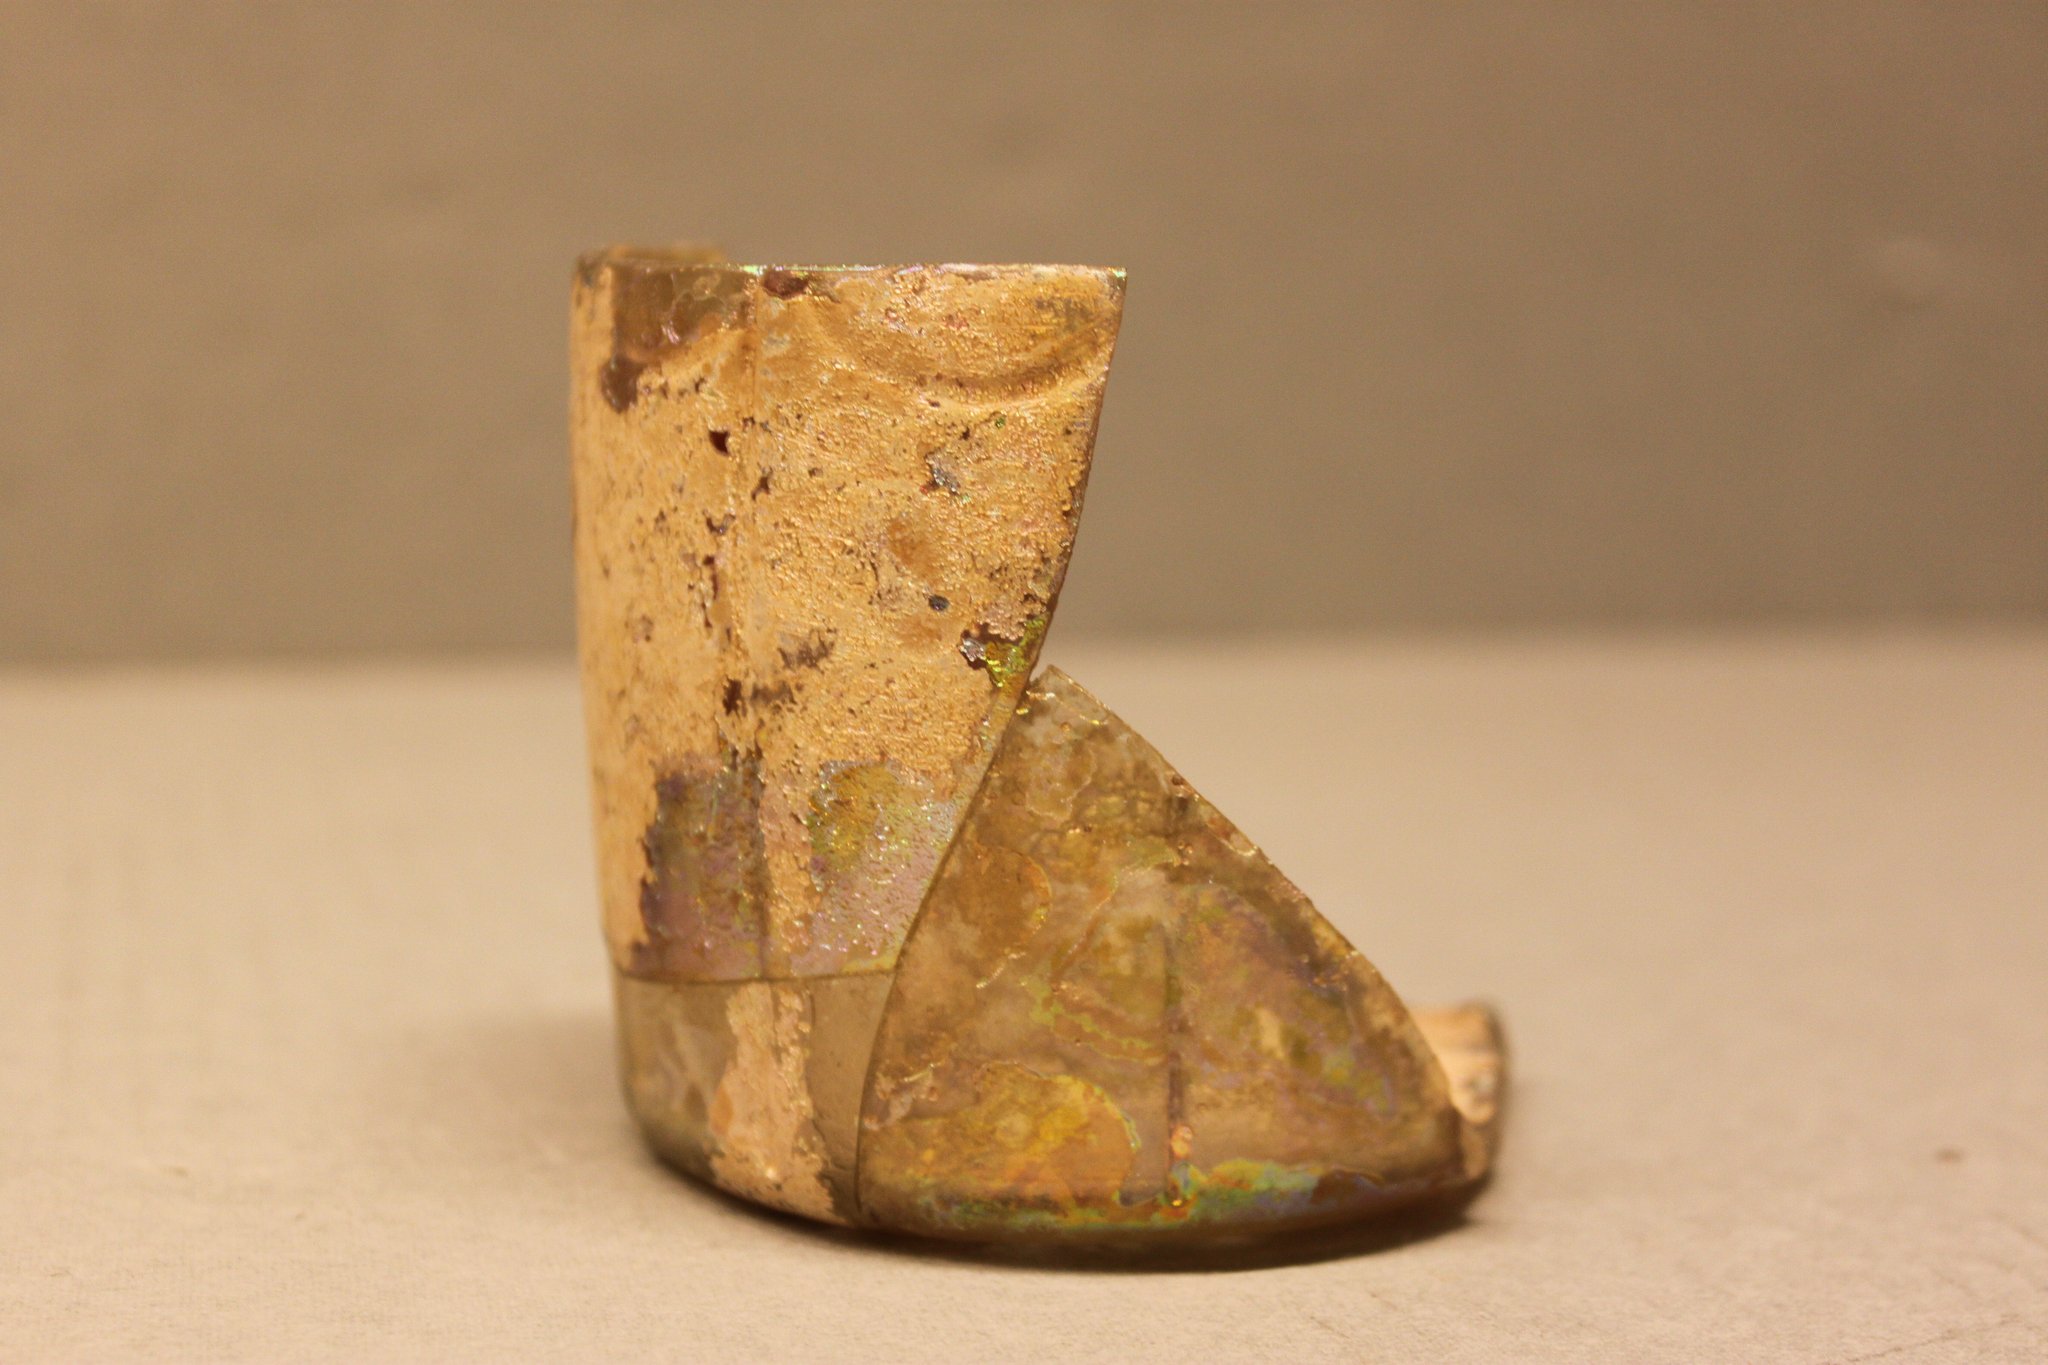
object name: fragment of a beaker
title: Beaker Fragment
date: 801-1000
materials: glass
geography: iran